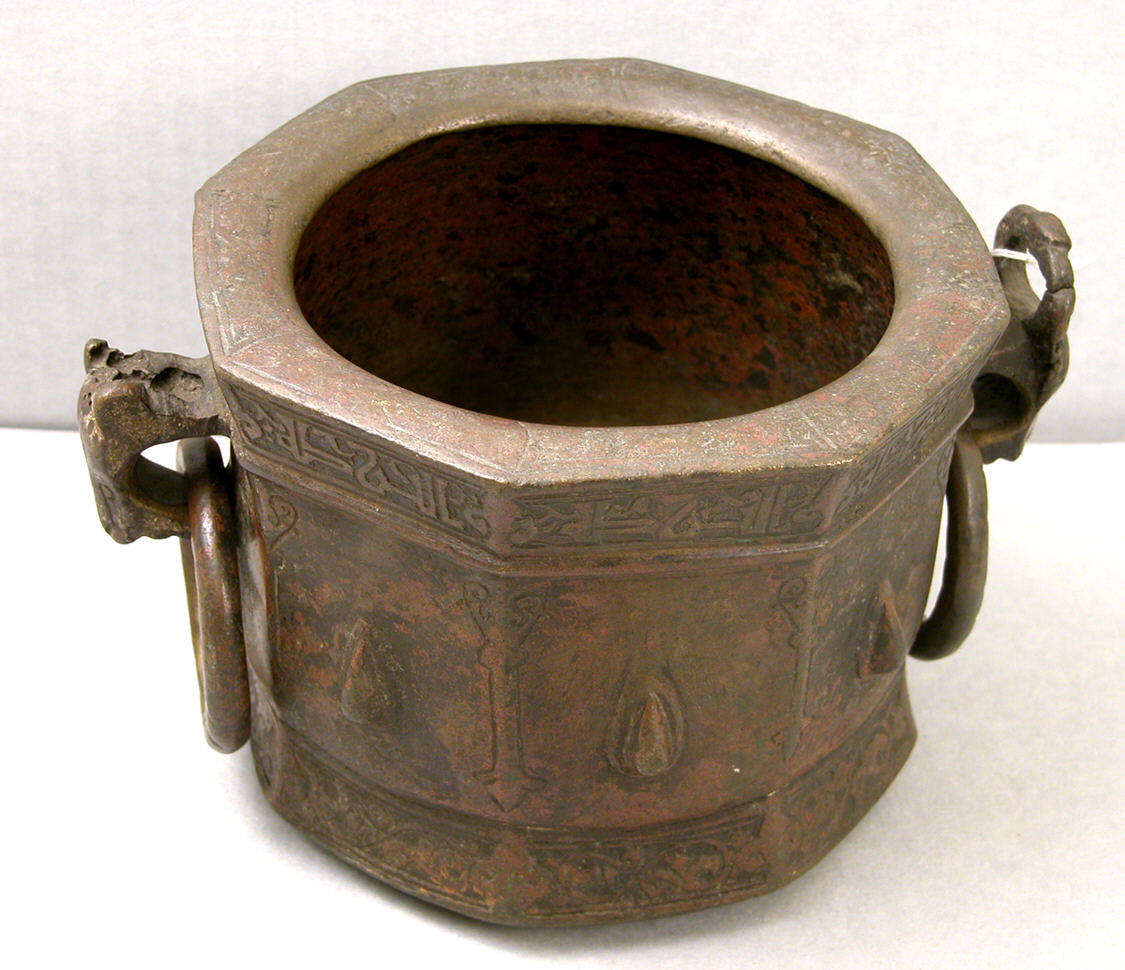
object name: mortar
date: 1101-1300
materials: bronze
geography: iran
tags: arabic